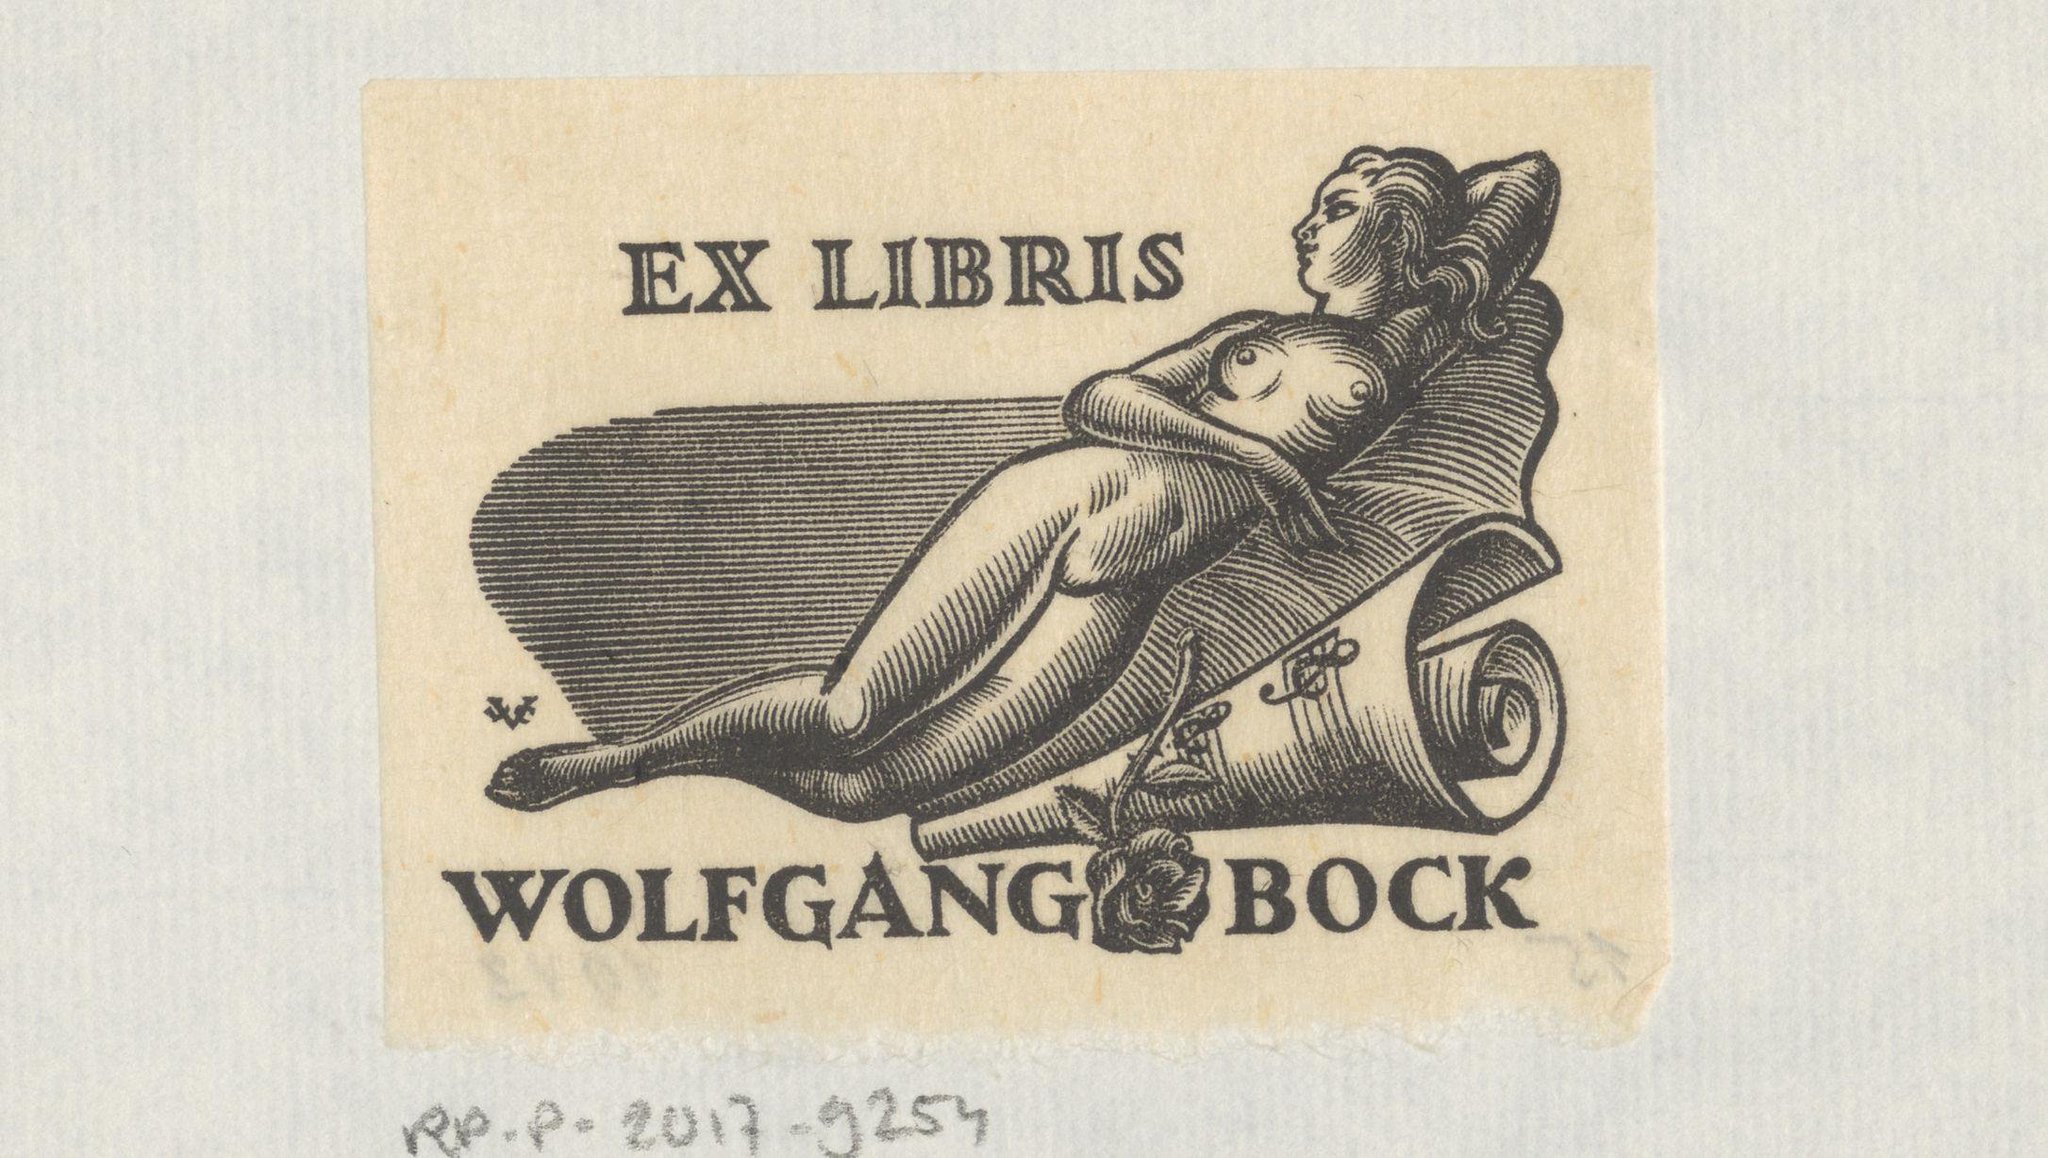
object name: bookplate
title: Ex libris van Wolfgang Bock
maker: valentin le campion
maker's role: print maker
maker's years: 1861-1952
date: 1951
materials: paper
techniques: woodcut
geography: france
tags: notation of music, woman (showing herself) undressed, quasi-nude